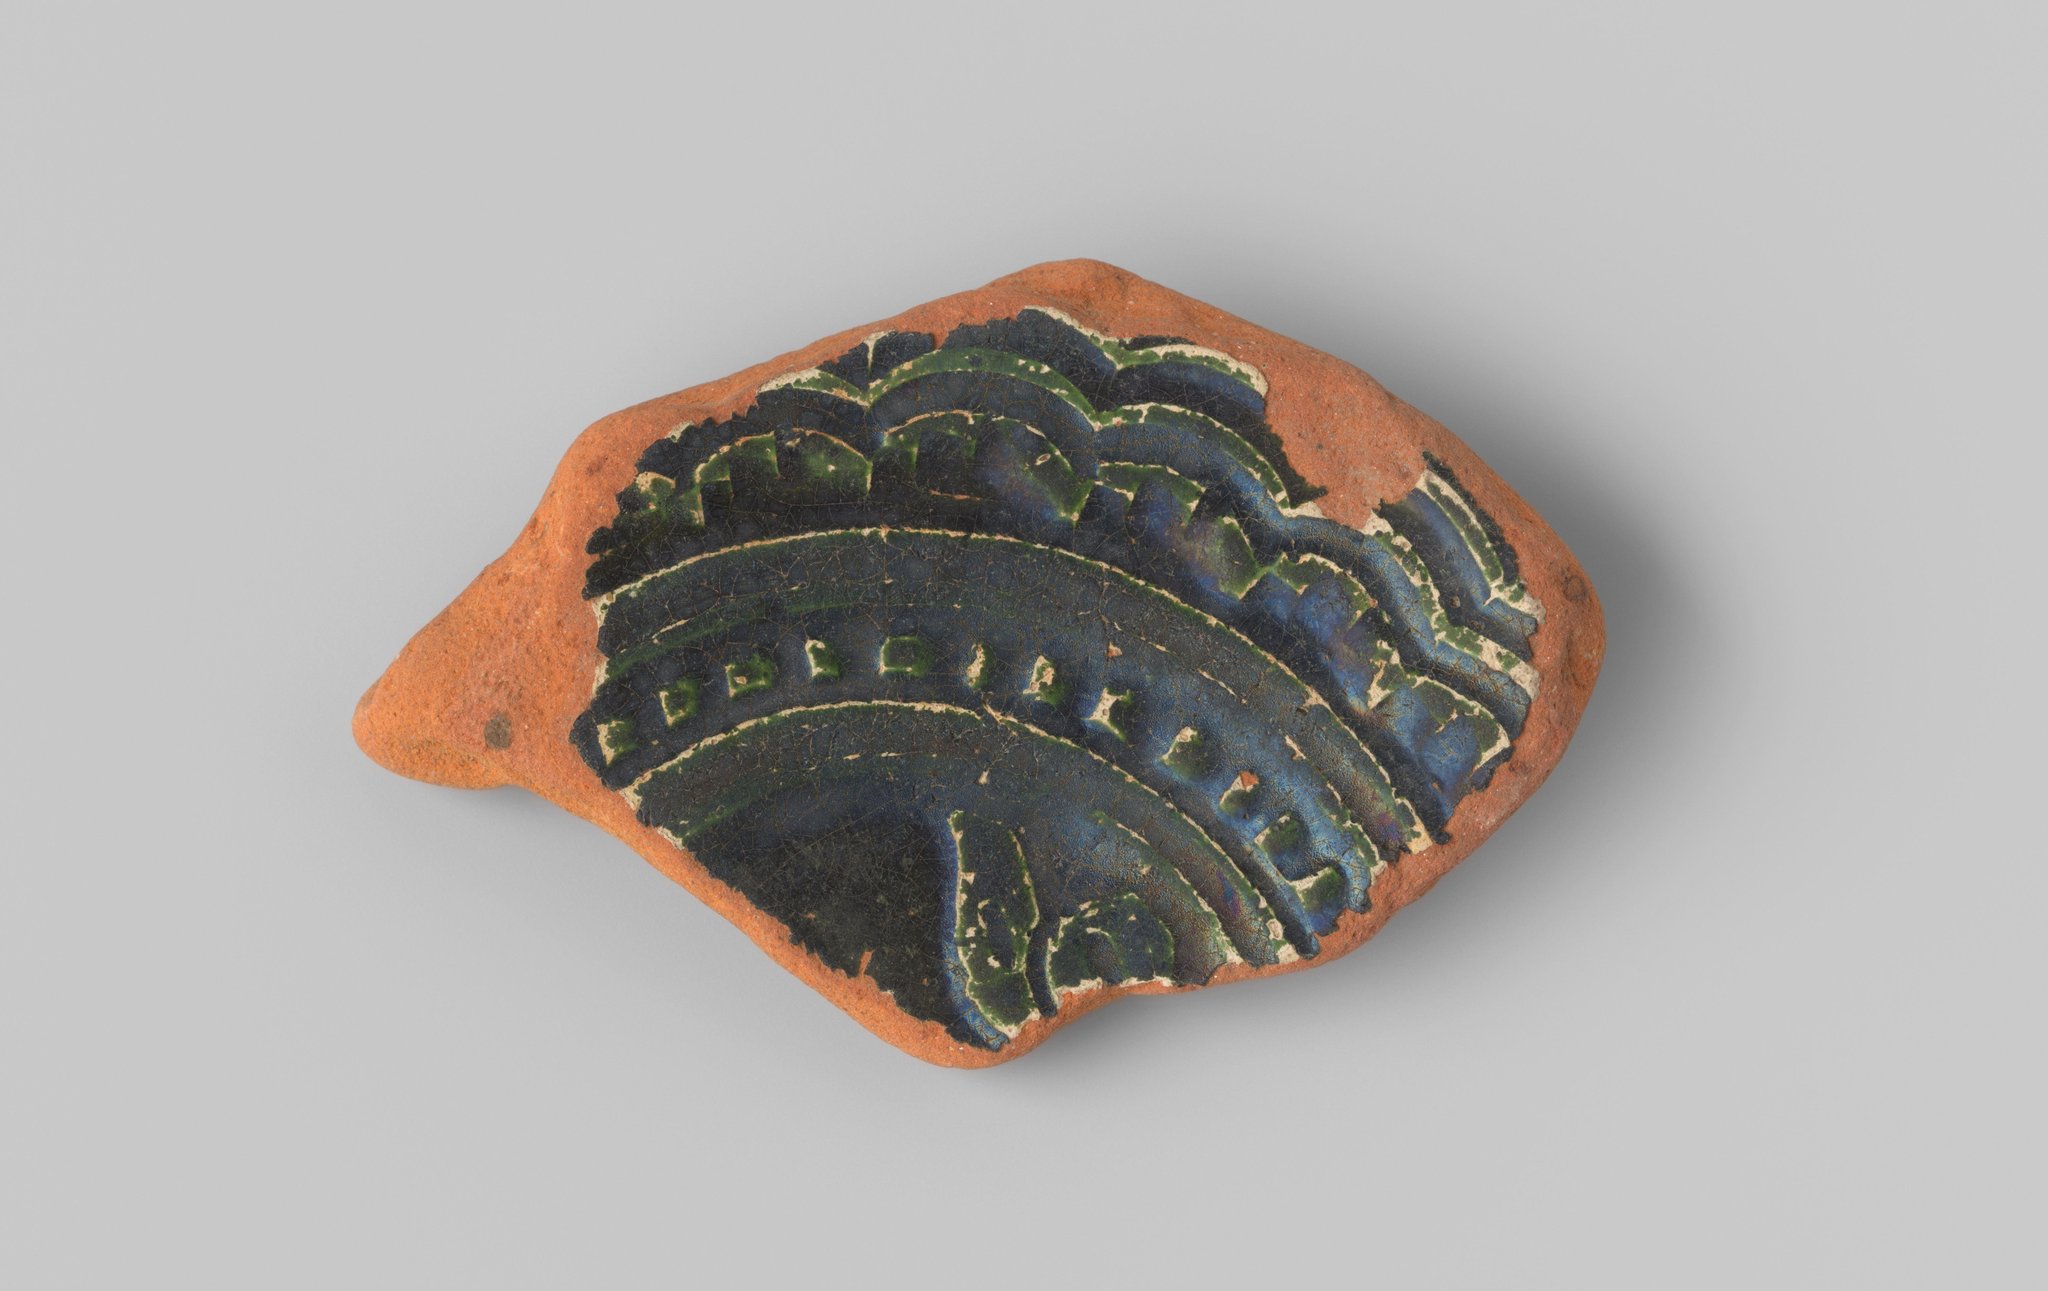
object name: sherd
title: Fragment van een schotel met roodbakkende scherf, met aan de voor- en achterzijde groen glazuur, waarop aan de voorzijde in sgrafitto-techniek sierranden zijn aangebracht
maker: Anonymous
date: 1200-1899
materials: earthenware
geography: italy